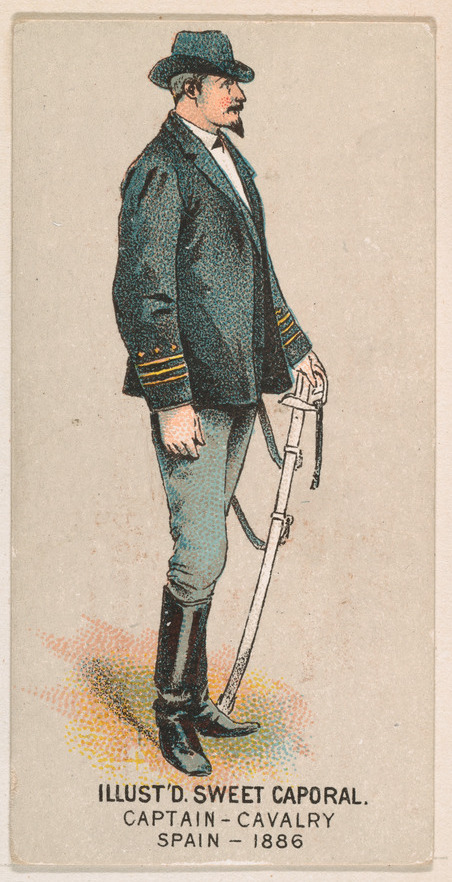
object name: print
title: Captain, Cavalry, Spain, 1886, from the Military Series (N224) issued by Kinney Tobacco Company to promote Sweet Caporal Cigarettes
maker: kinney brothers tobacco company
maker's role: publisher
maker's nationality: american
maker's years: 1869-2011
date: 1888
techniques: color lithograph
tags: military,men,profiles